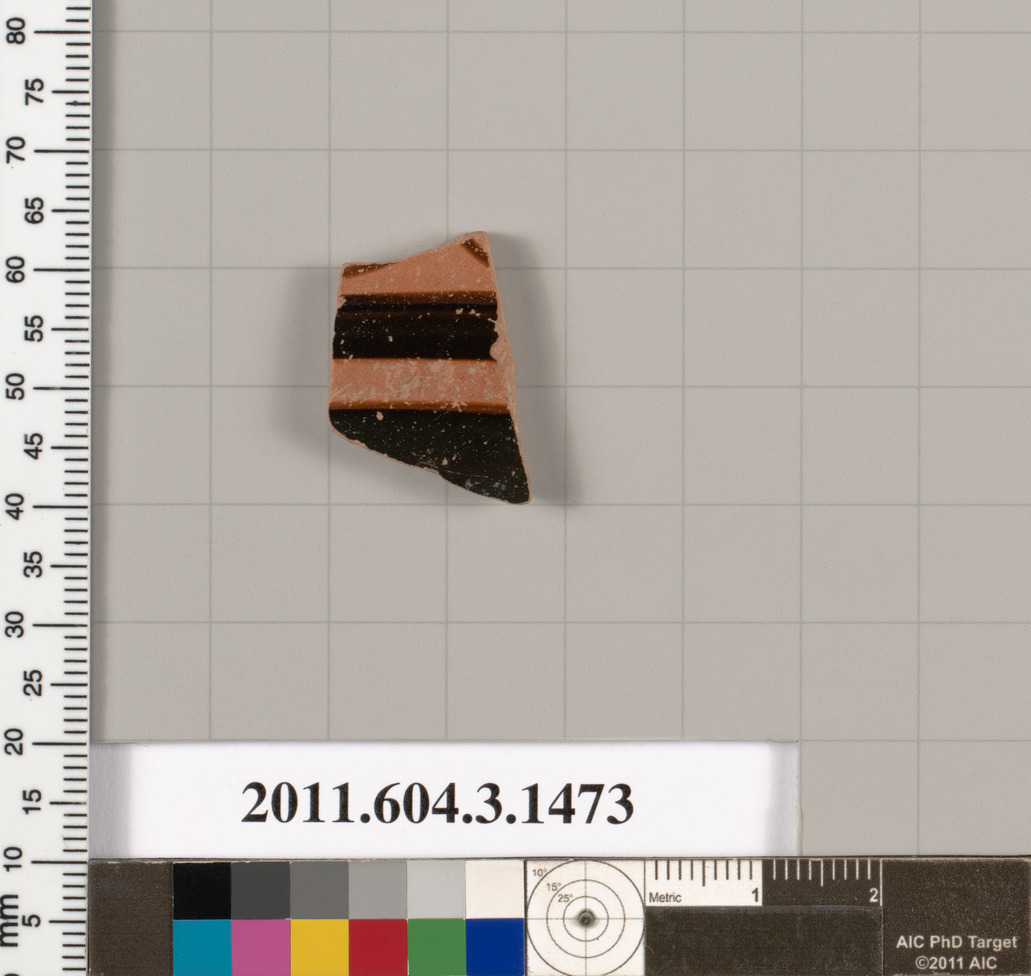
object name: skyphos fragment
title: Terracotta fragment of a skyphos (deep drinking cup)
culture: greek, attic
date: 600-401 BCE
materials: terracotta